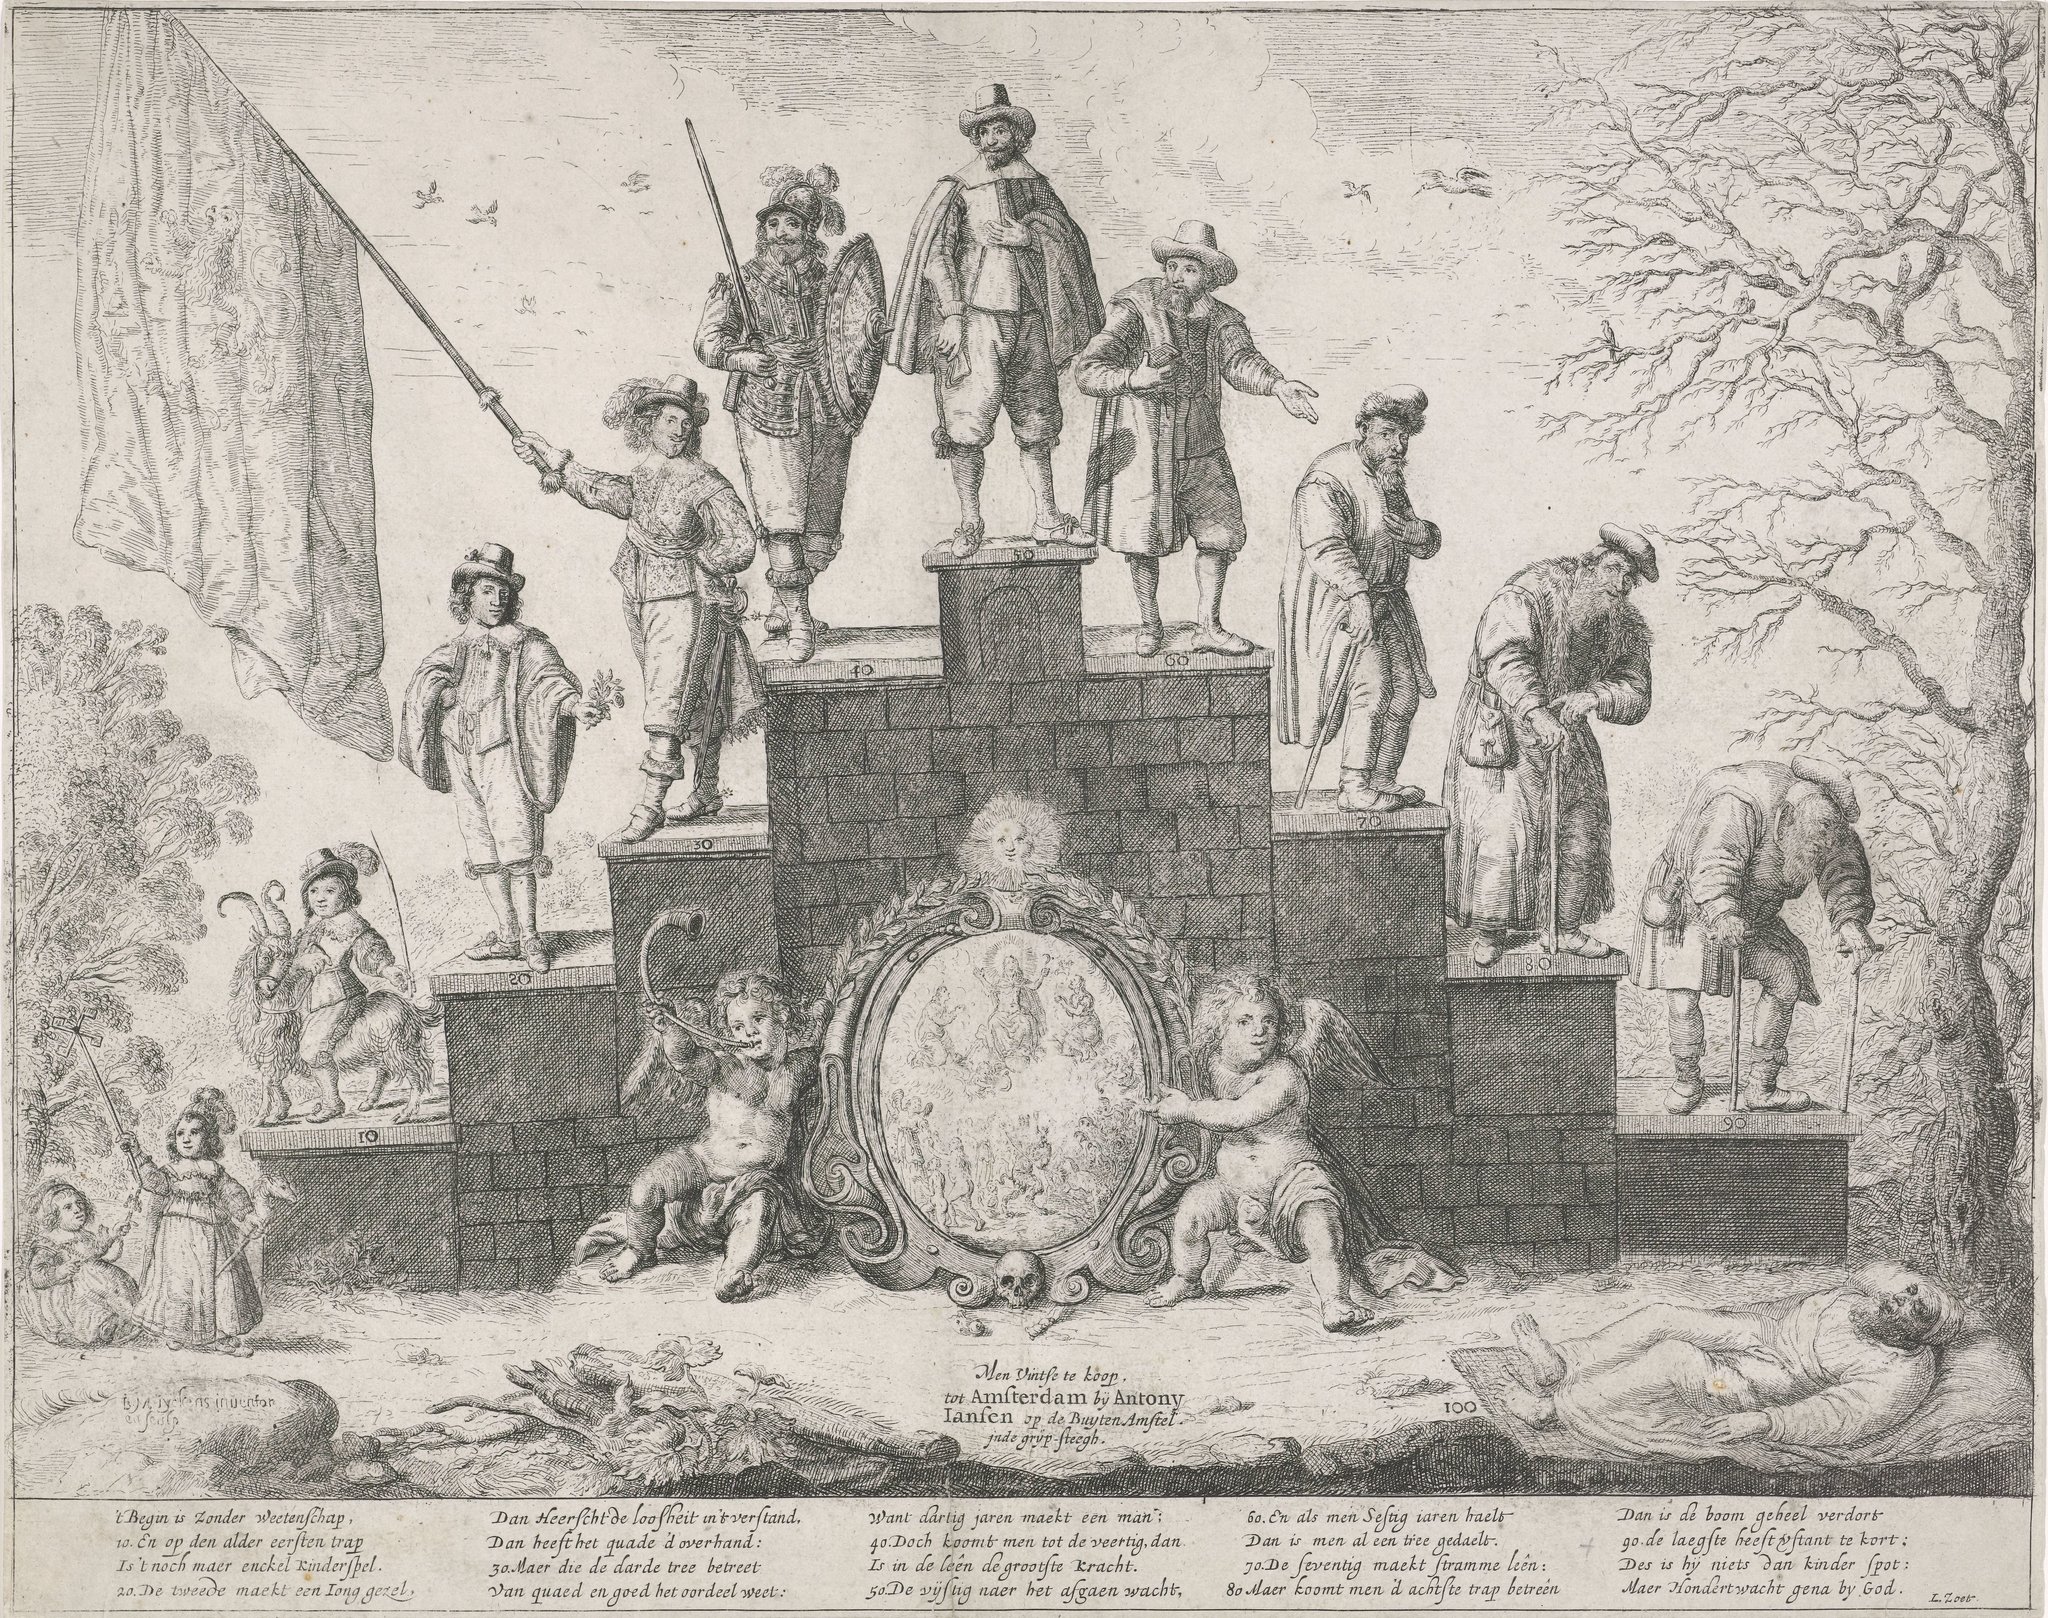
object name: print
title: Trap des Levens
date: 1637-1648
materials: paper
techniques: engraving, etching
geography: amsterdam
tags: last judgement, the ages of man represented by a staircase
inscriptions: collector's mark: Lugt 2228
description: De Trap des Levens van de man. De trap heeft negen treden. Op iedere traptrede staat een man en op de traptrede de bijbehorende leeftijd. Rechts de jonge jaren van nul tot vijftig, links de ouderdom van vijftig tot honderd. Voor de trap houden twee putti een cartouche vast met de voorstelling van het laatste oordeel. Onder in de marge vijf vierregelige verzen in het Nederlands.